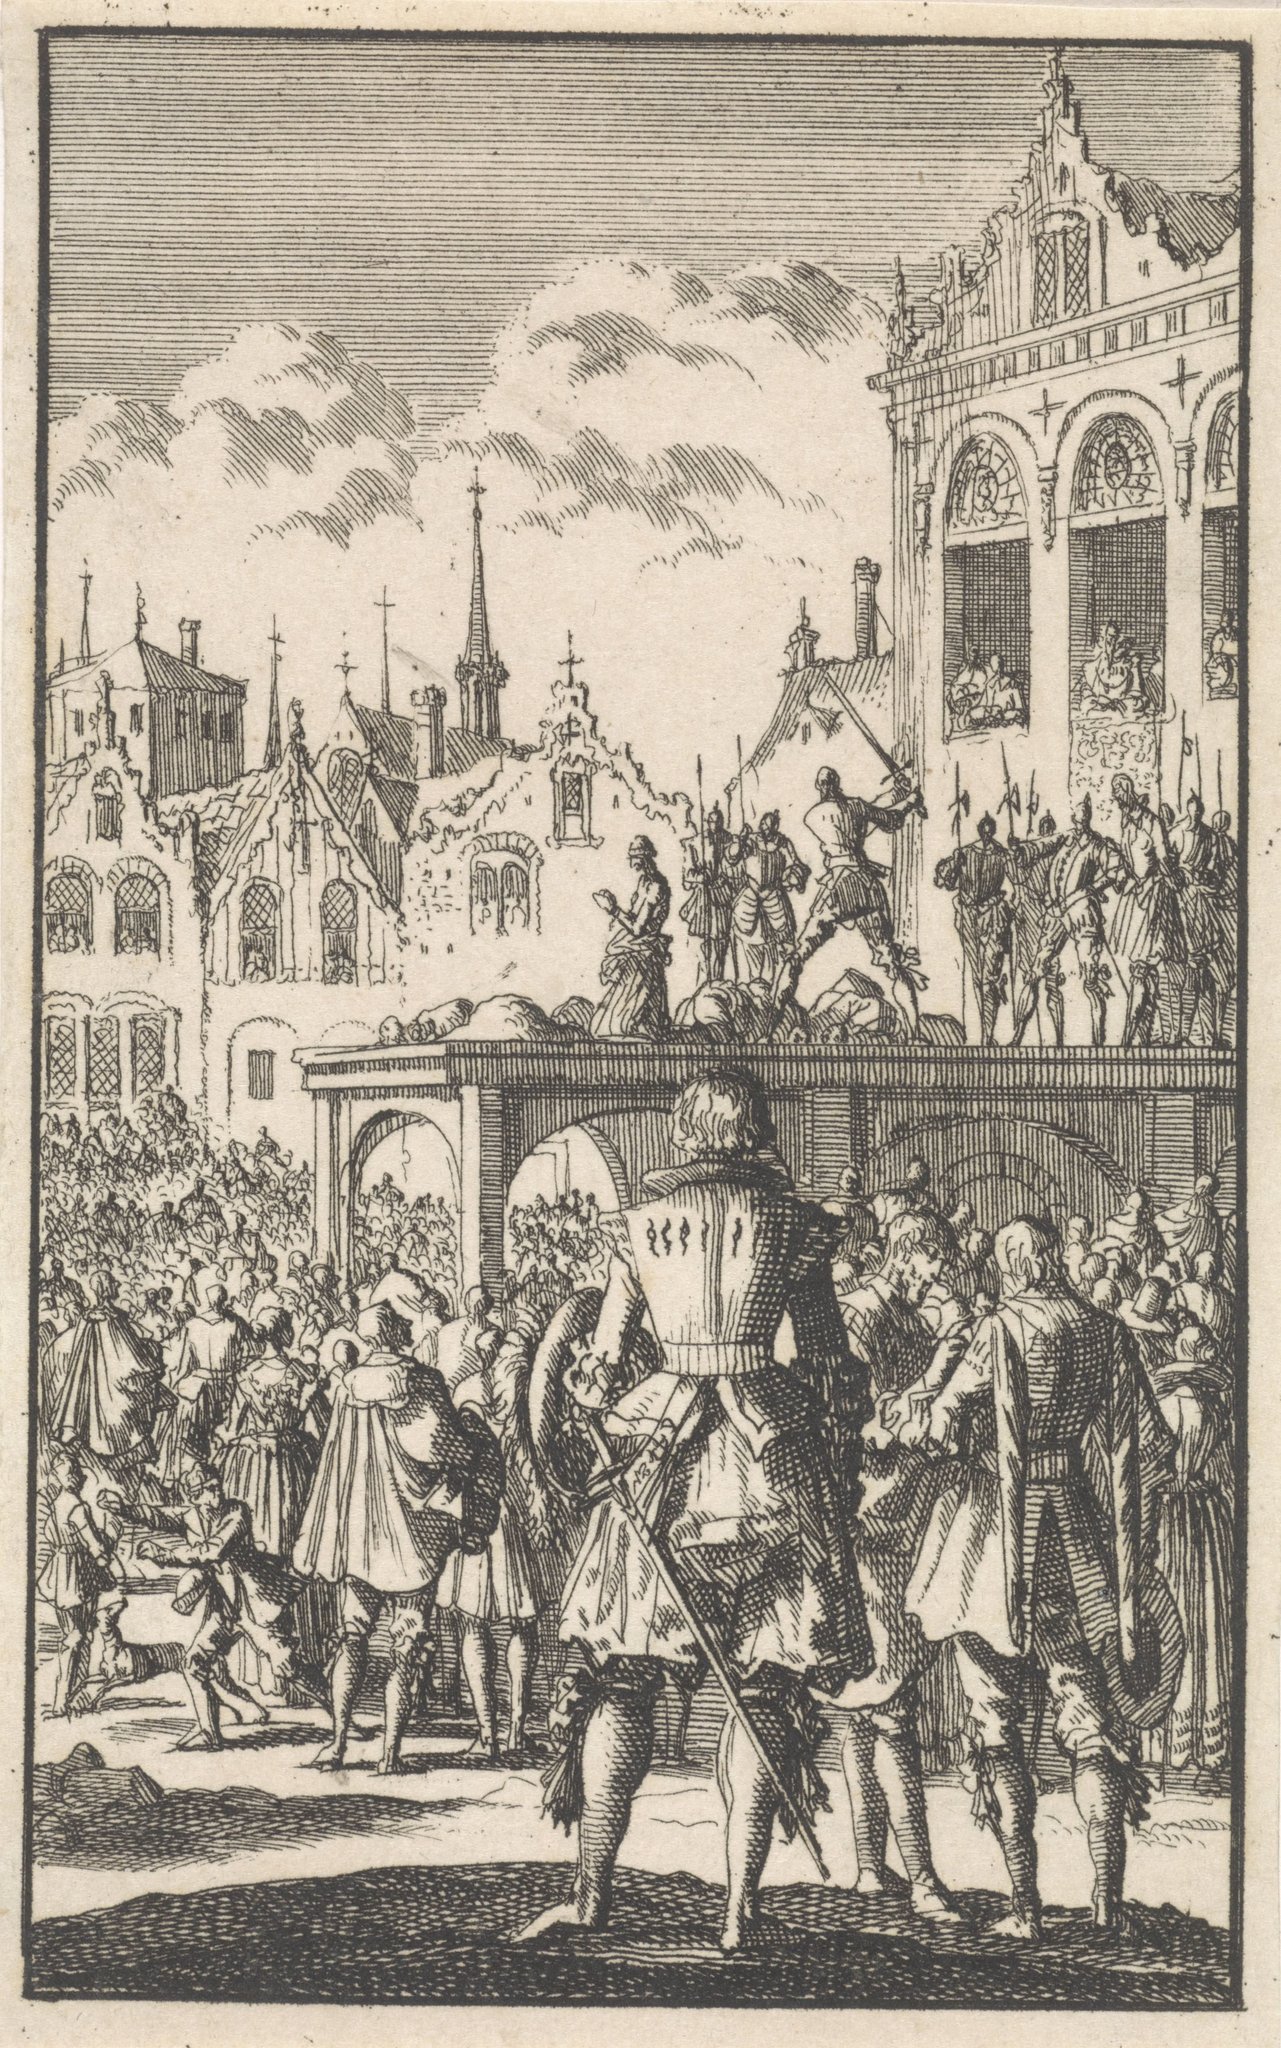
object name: print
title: Onthoofding van de graven Egmond en Horne, 1567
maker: jan luyken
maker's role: draughtsman, print maker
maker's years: 1649-1712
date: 1699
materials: paper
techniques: etching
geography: amsterdam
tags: grote markt, terechtstelling van egmond en horne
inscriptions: collector's mark: Lugt 2228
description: De graven Egmond en Horne worden samen met andere edelen op de Grote Markt van Brussel met het zwaard onthoofd op bevel van de hertog van Alva. Een menigte heeft zich rond het schavot verzameld.